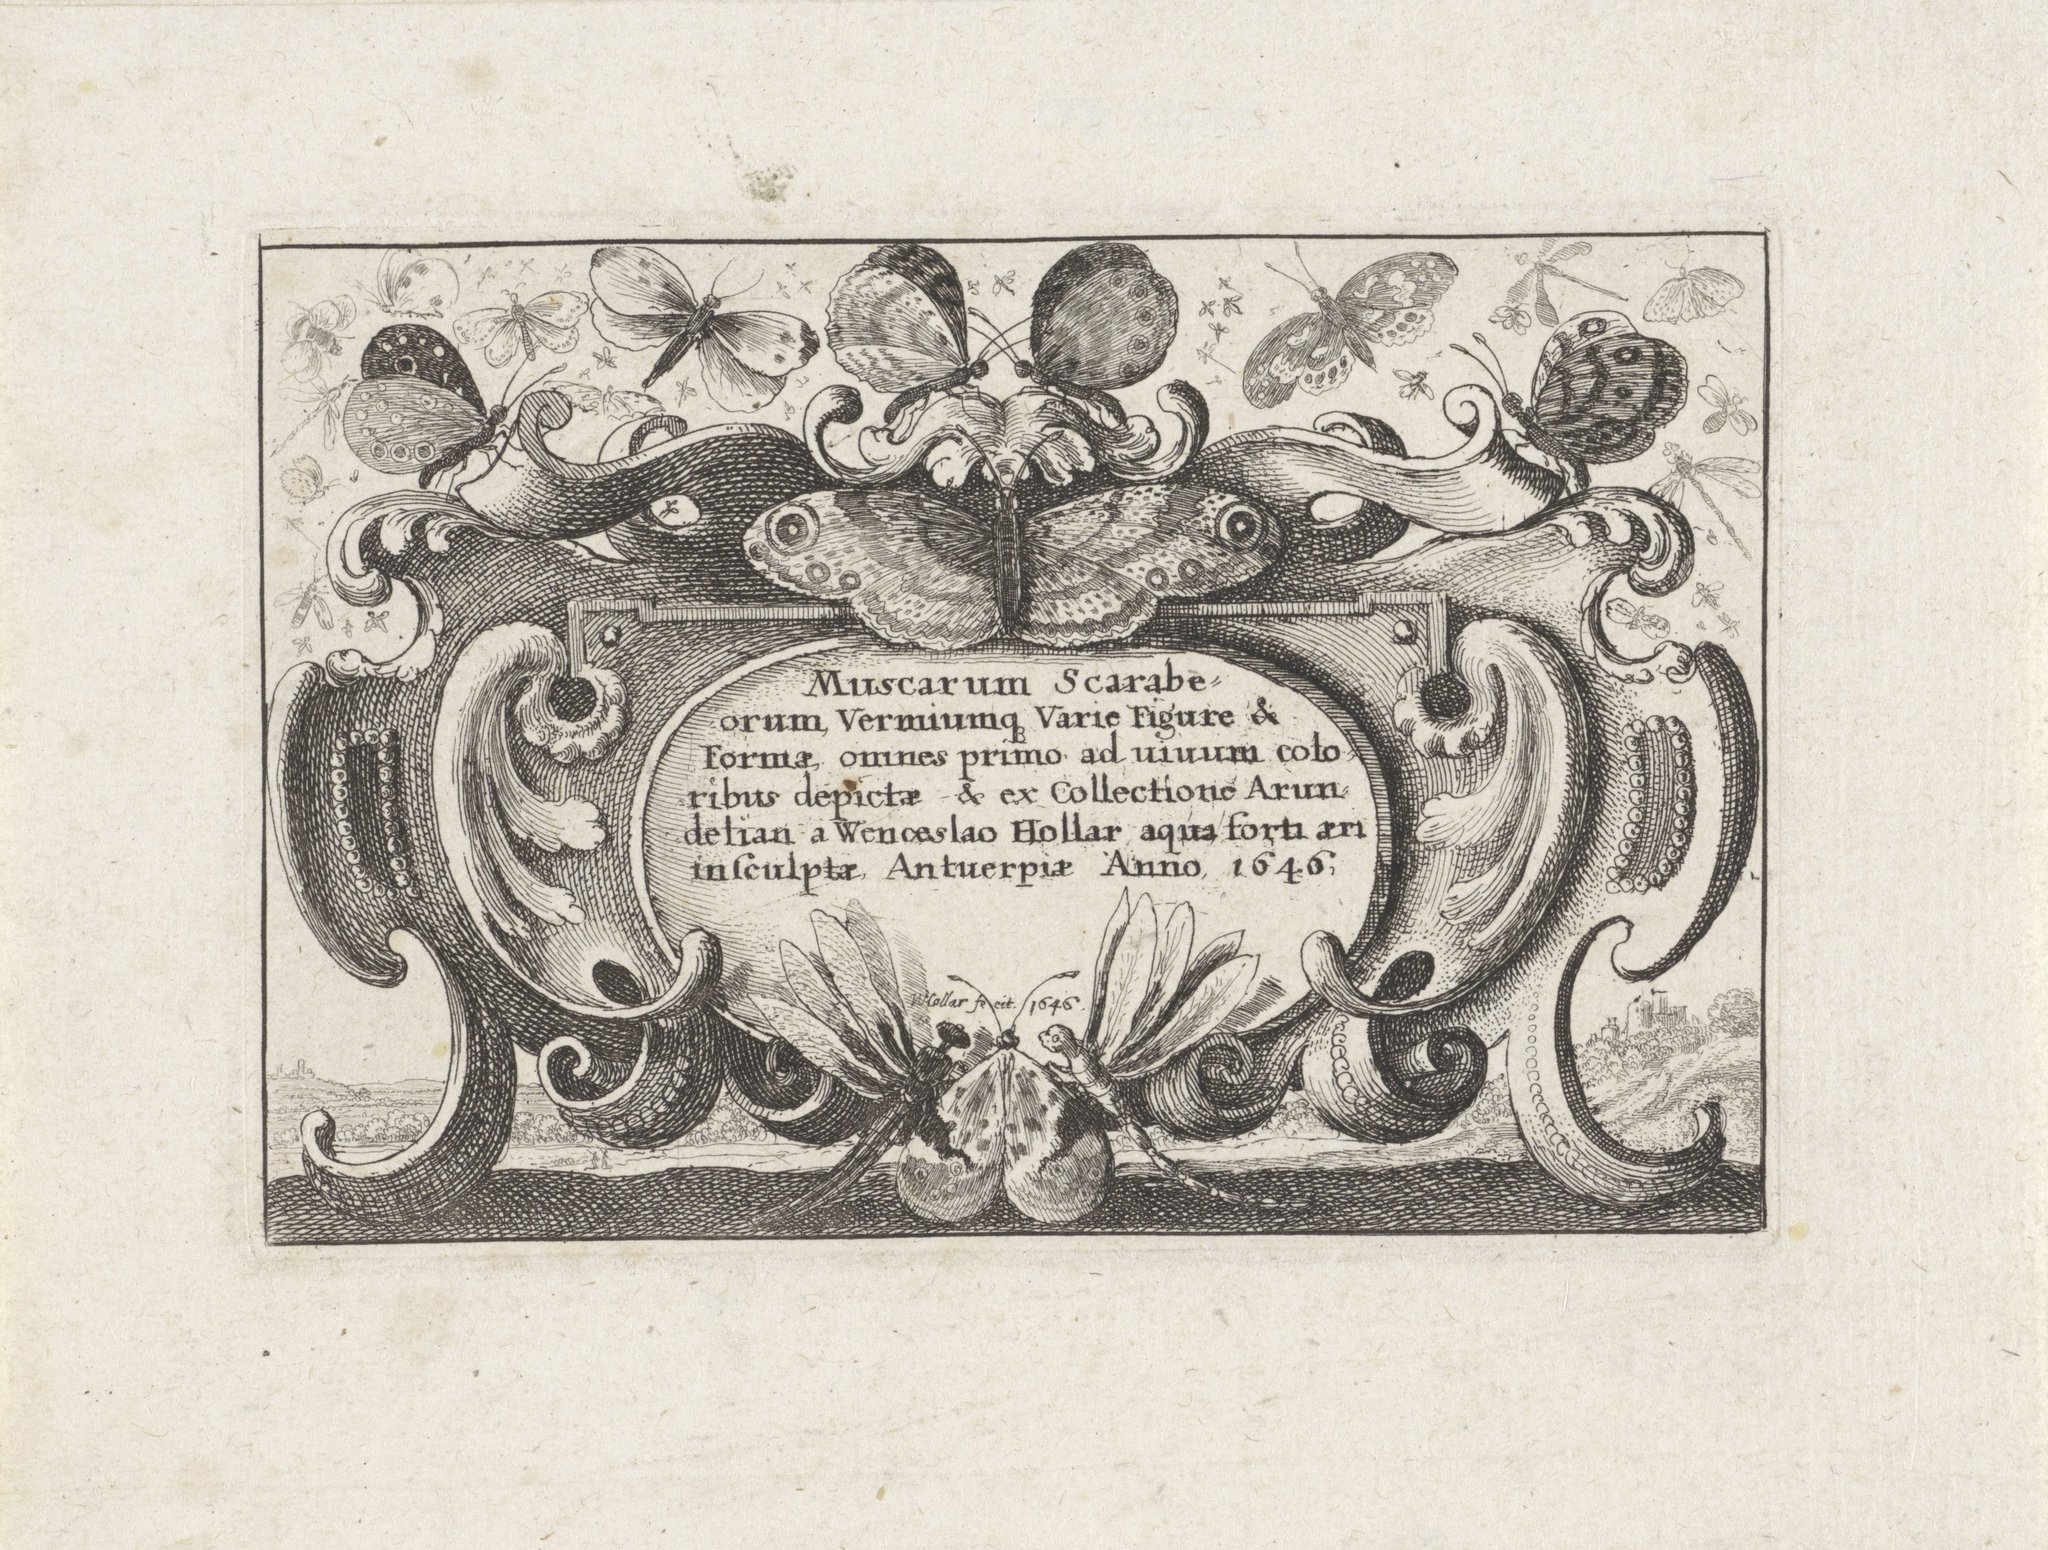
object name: print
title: Insecten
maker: wenceslaus hollar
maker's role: draughtsman, print maker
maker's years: 1607-1677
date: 1646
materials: paper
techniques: etching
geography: antwerp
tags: insects: butterfly, insects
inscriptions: collector's mark: Lugt 240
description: Titelprent voor de twaalfdelige serie met verschillende insecten: "Muscarum Scarabeorum".